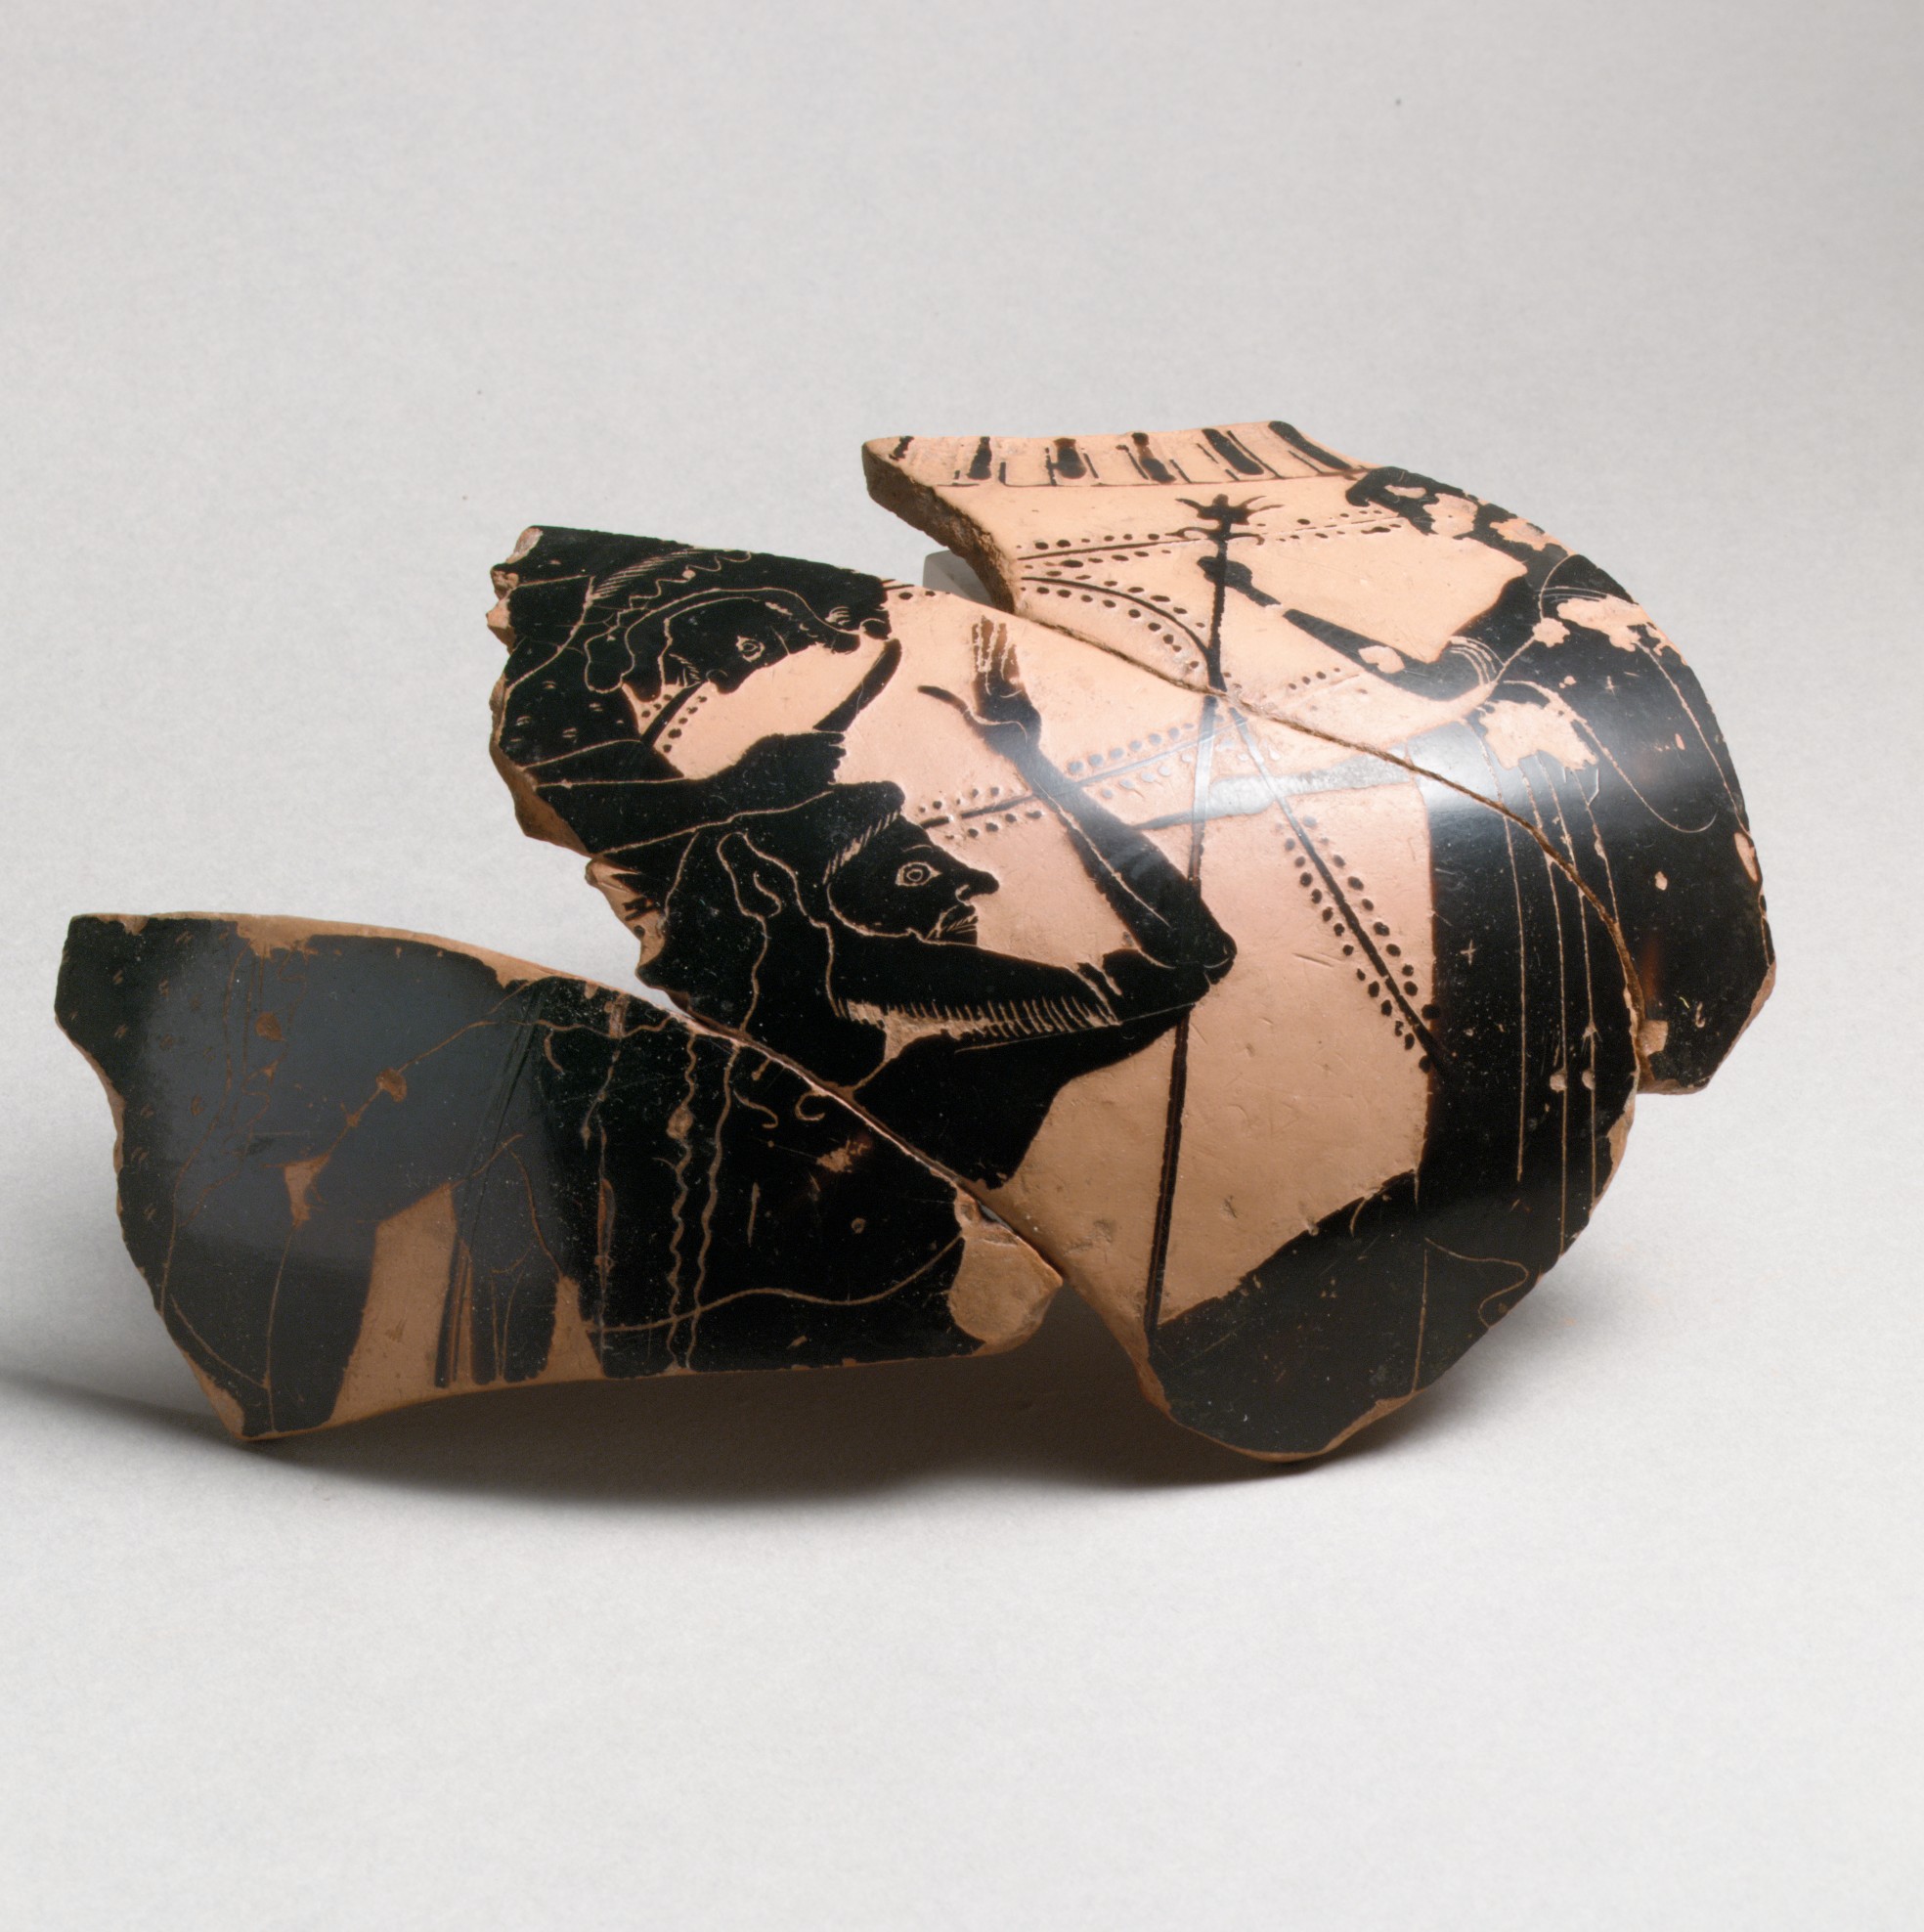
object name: neck amphora, fragmentary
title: Neck-amphora, fragmentary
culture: greek, attic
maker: leagros group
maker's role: artist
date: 525-500 BCE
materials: terracotta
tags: human figures